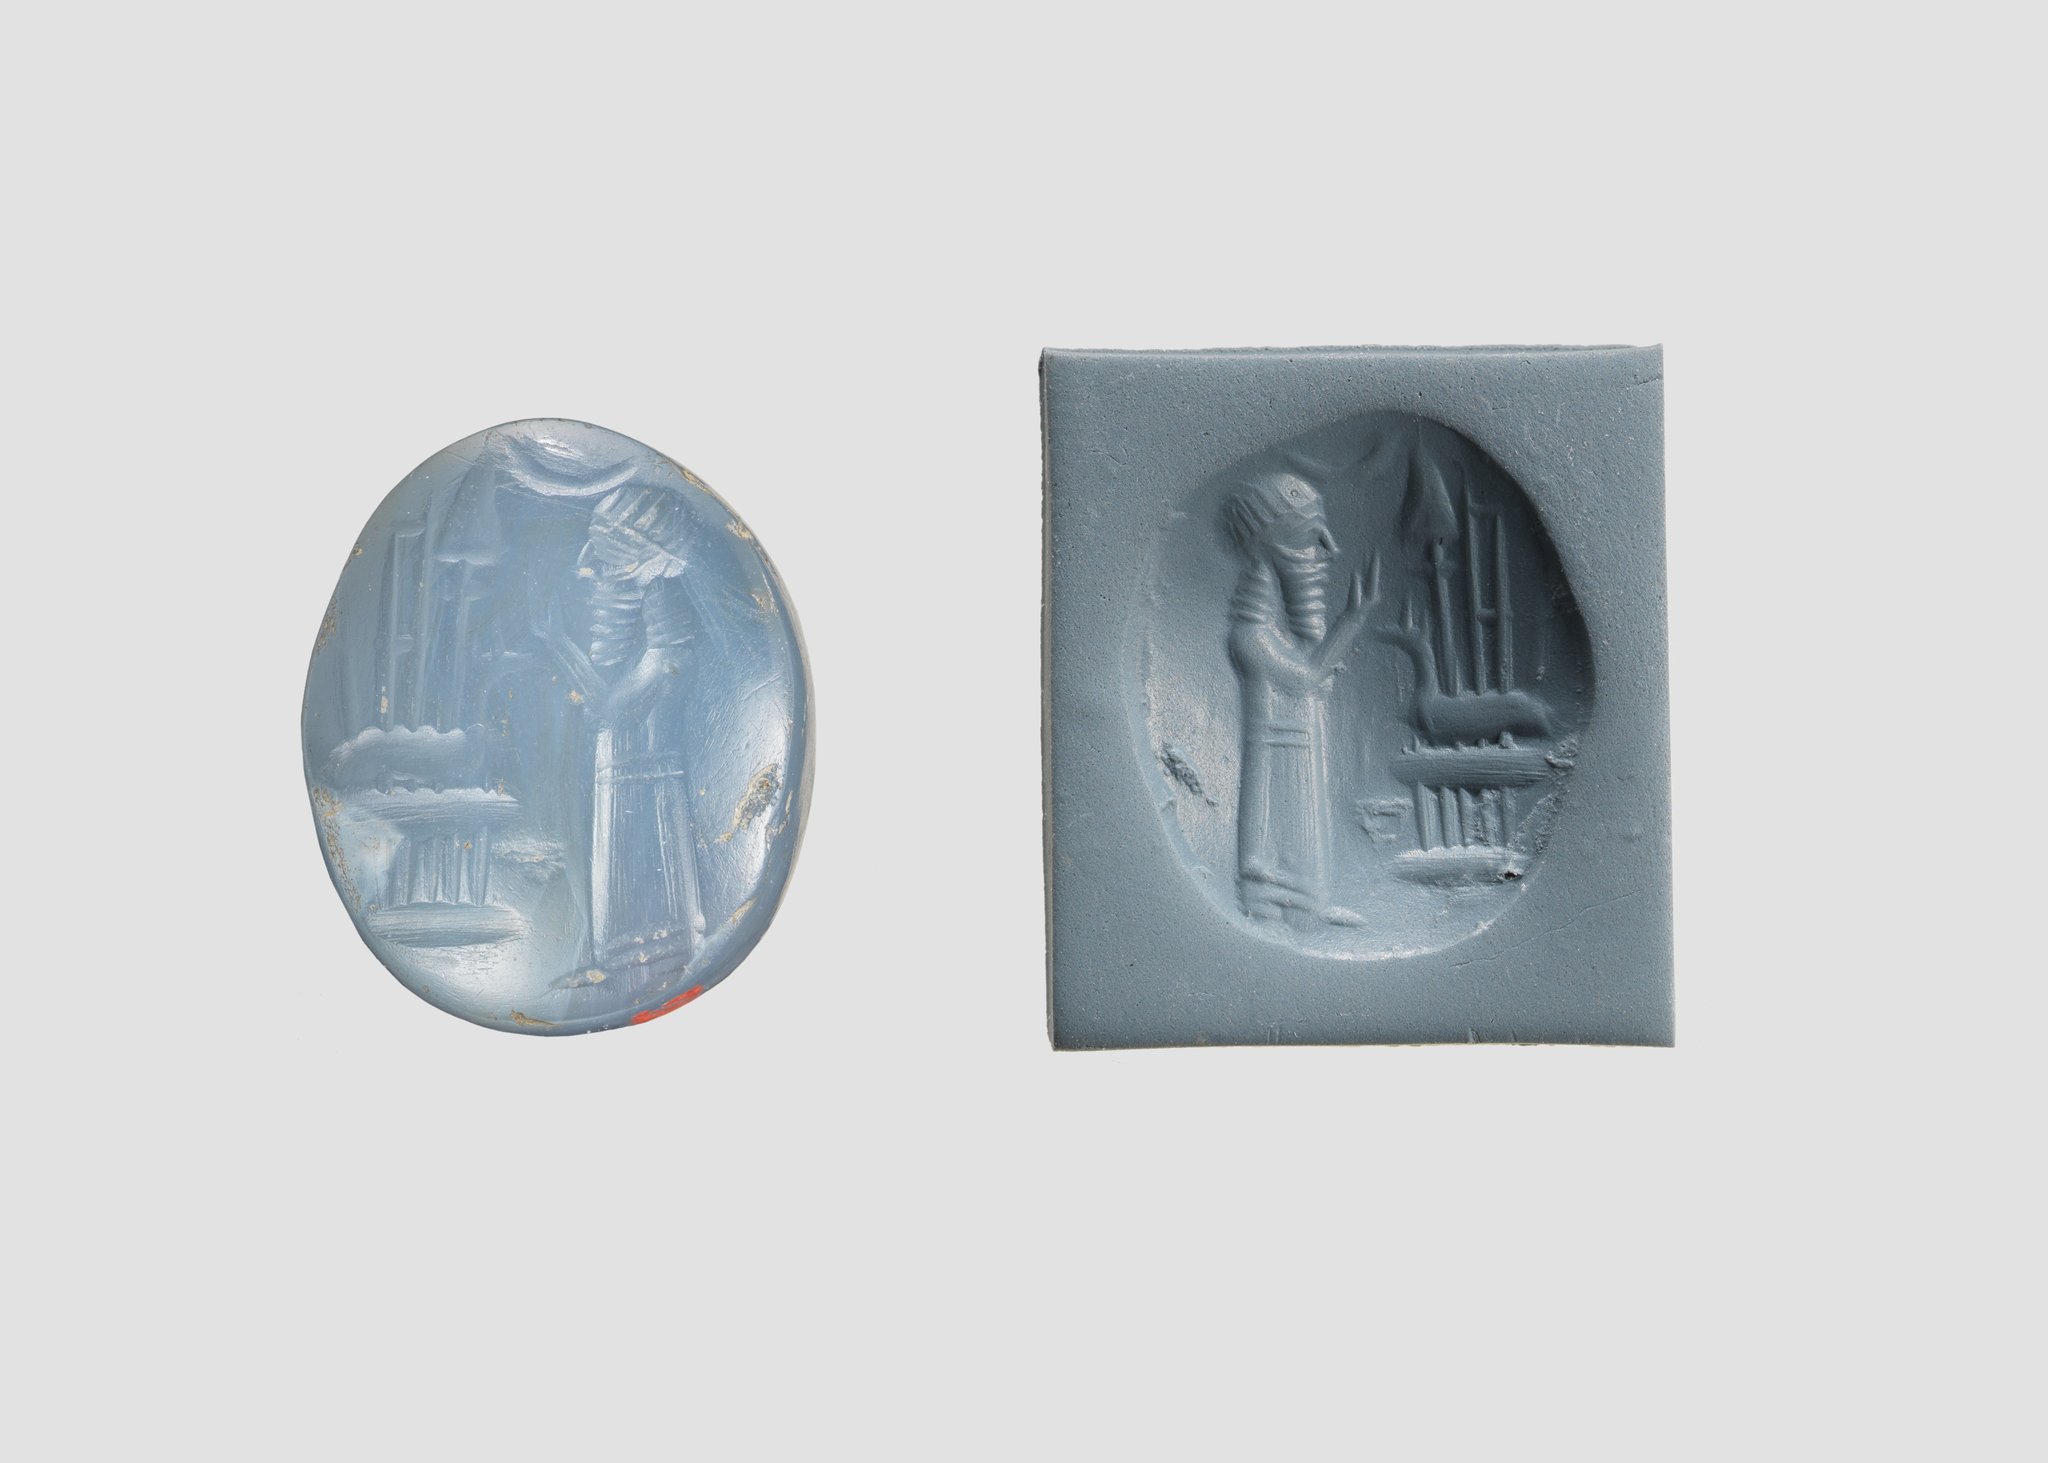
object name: stamp seal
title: Stamp seal (oval conoid) with cultic scene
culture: assyro-babylonian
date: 734-501 BCE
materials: stone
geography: mesopotamia